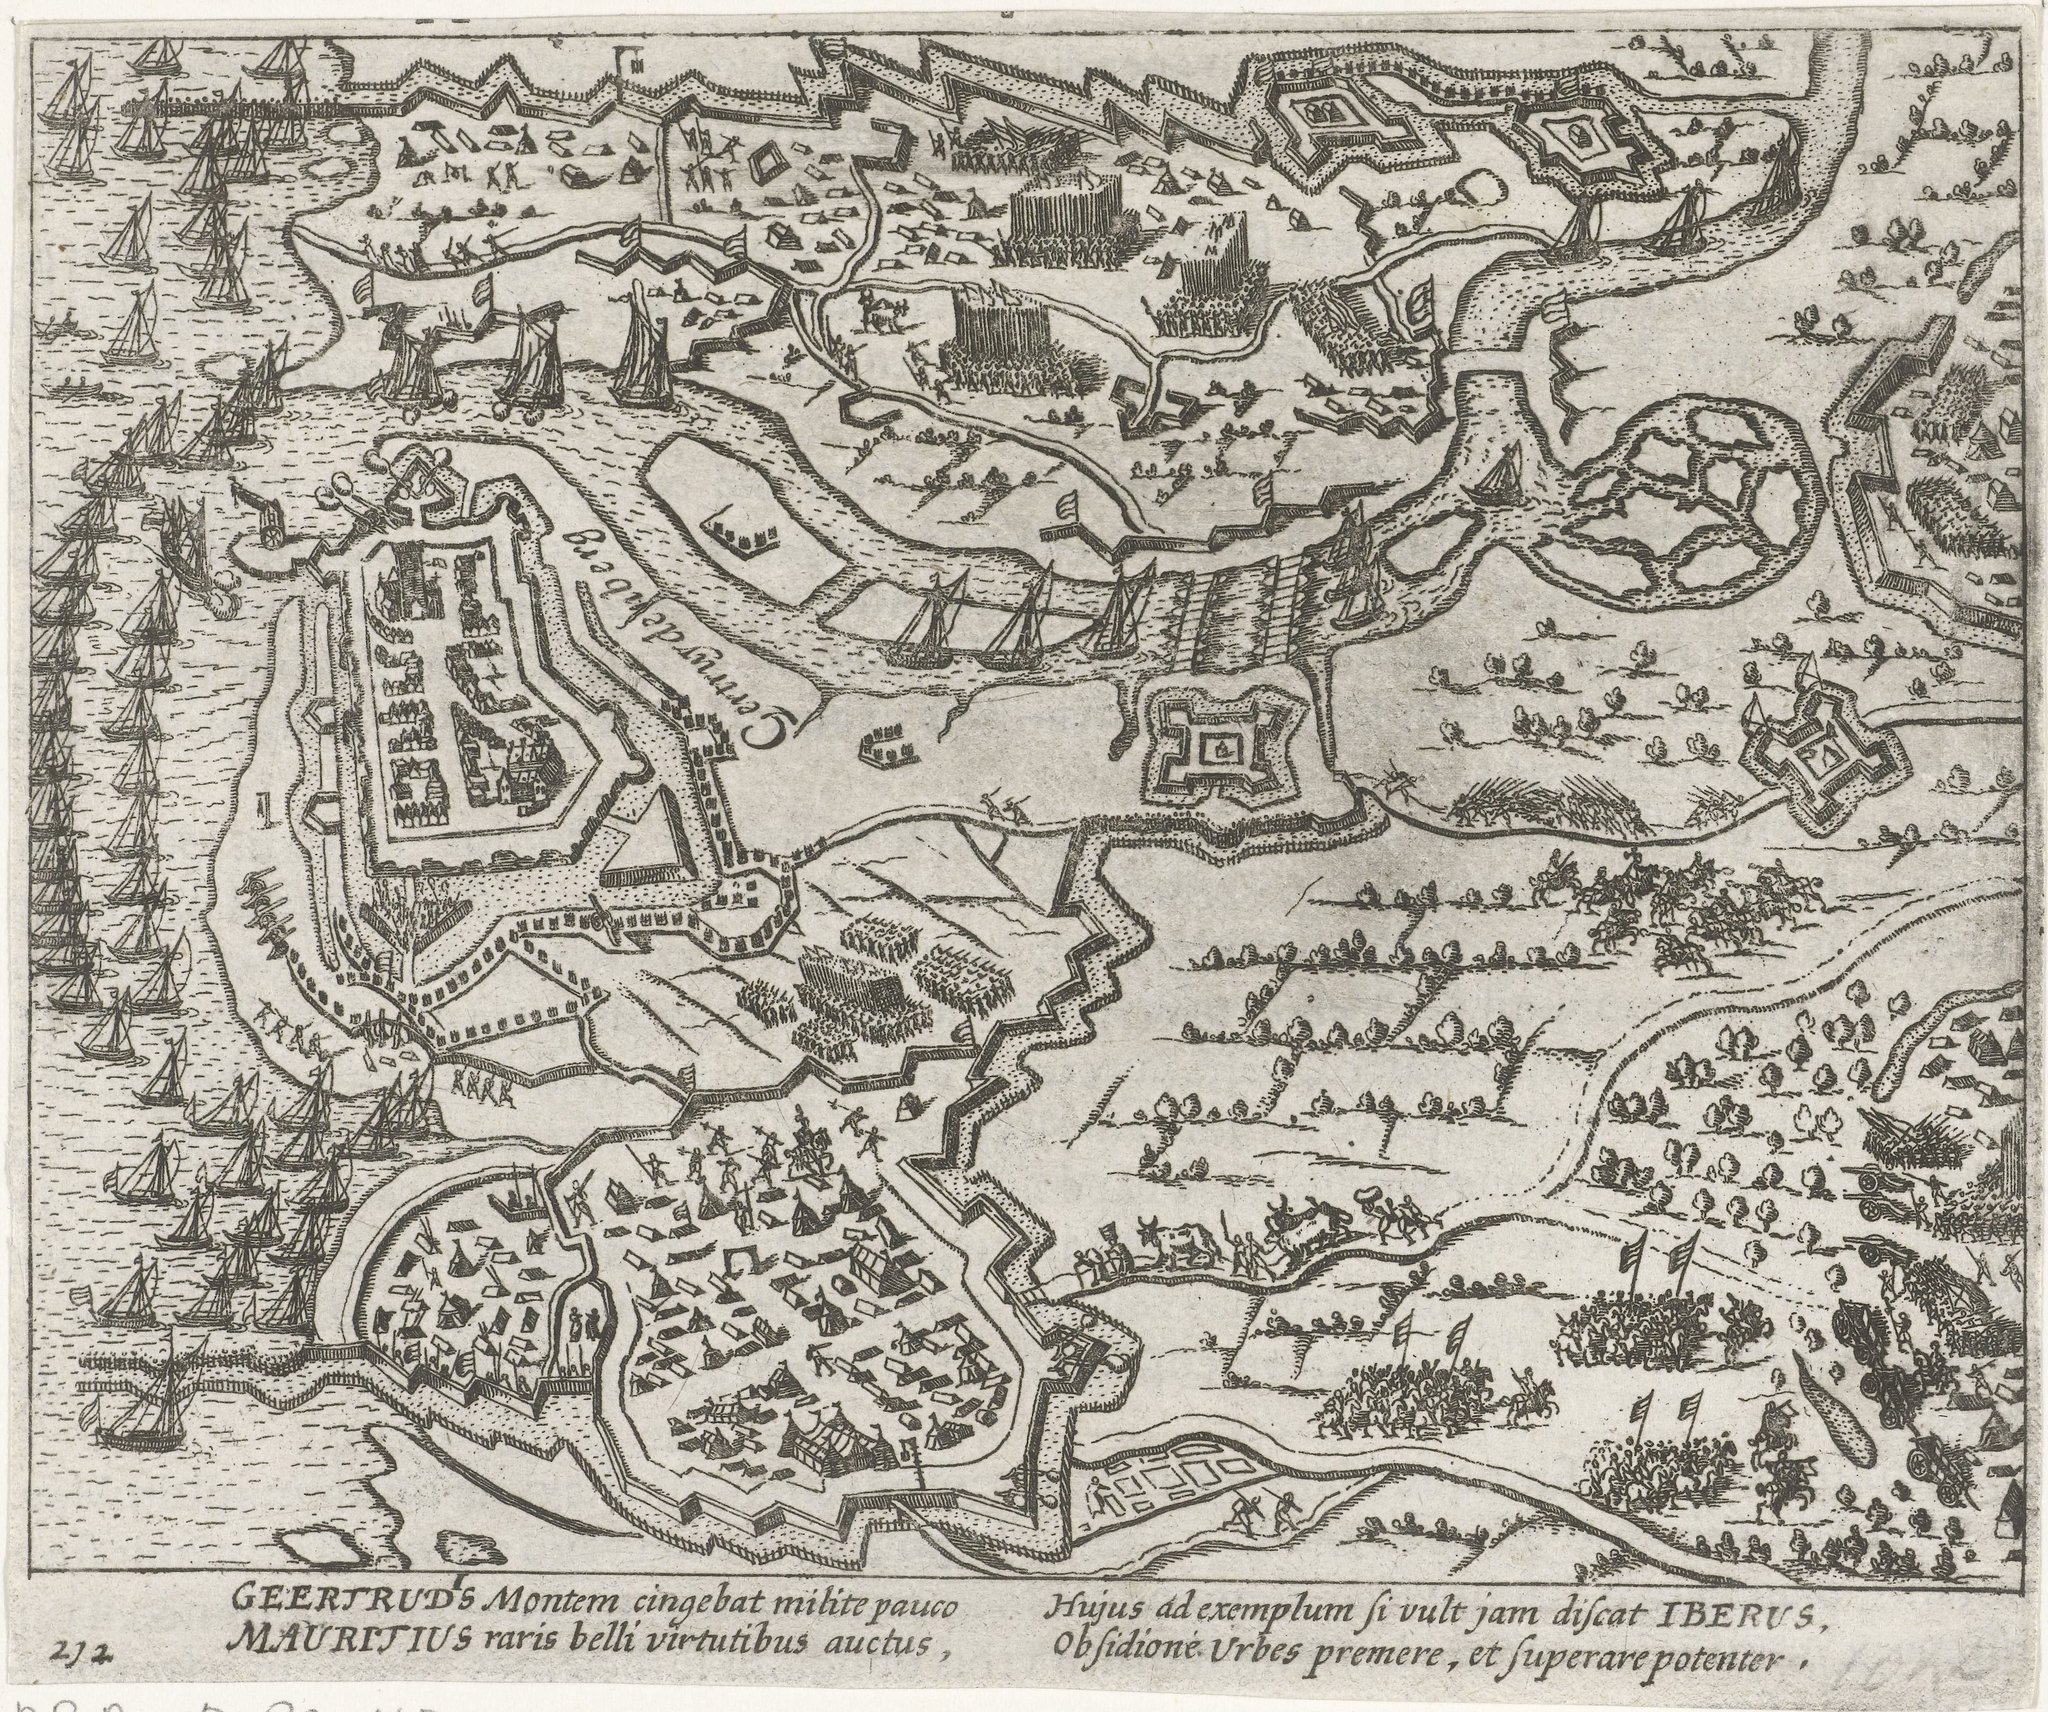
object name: print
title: Beleg van Geertruidenberg, 1593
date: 1613-1615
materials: paper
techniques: etching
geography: northern netherlands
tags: the hague, maurice (prince of orange), maps of separate countries or regions, siege, position war, geertruidenberg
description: Beleg van Geertruidenberg, 28 maart - 26 juni 1593, door het Staatse leger onder prins Maurits. Plan van de stad en de nabije omgeving met de posities van de belegerende troepen en de Spaanse troepen. Links de afgesloten haven aan de Biesbos. Met onderschrift van 4 regels in het Latijn. Genummerd 212. Bedrukt op achterzijde met tekst in het Latijn.